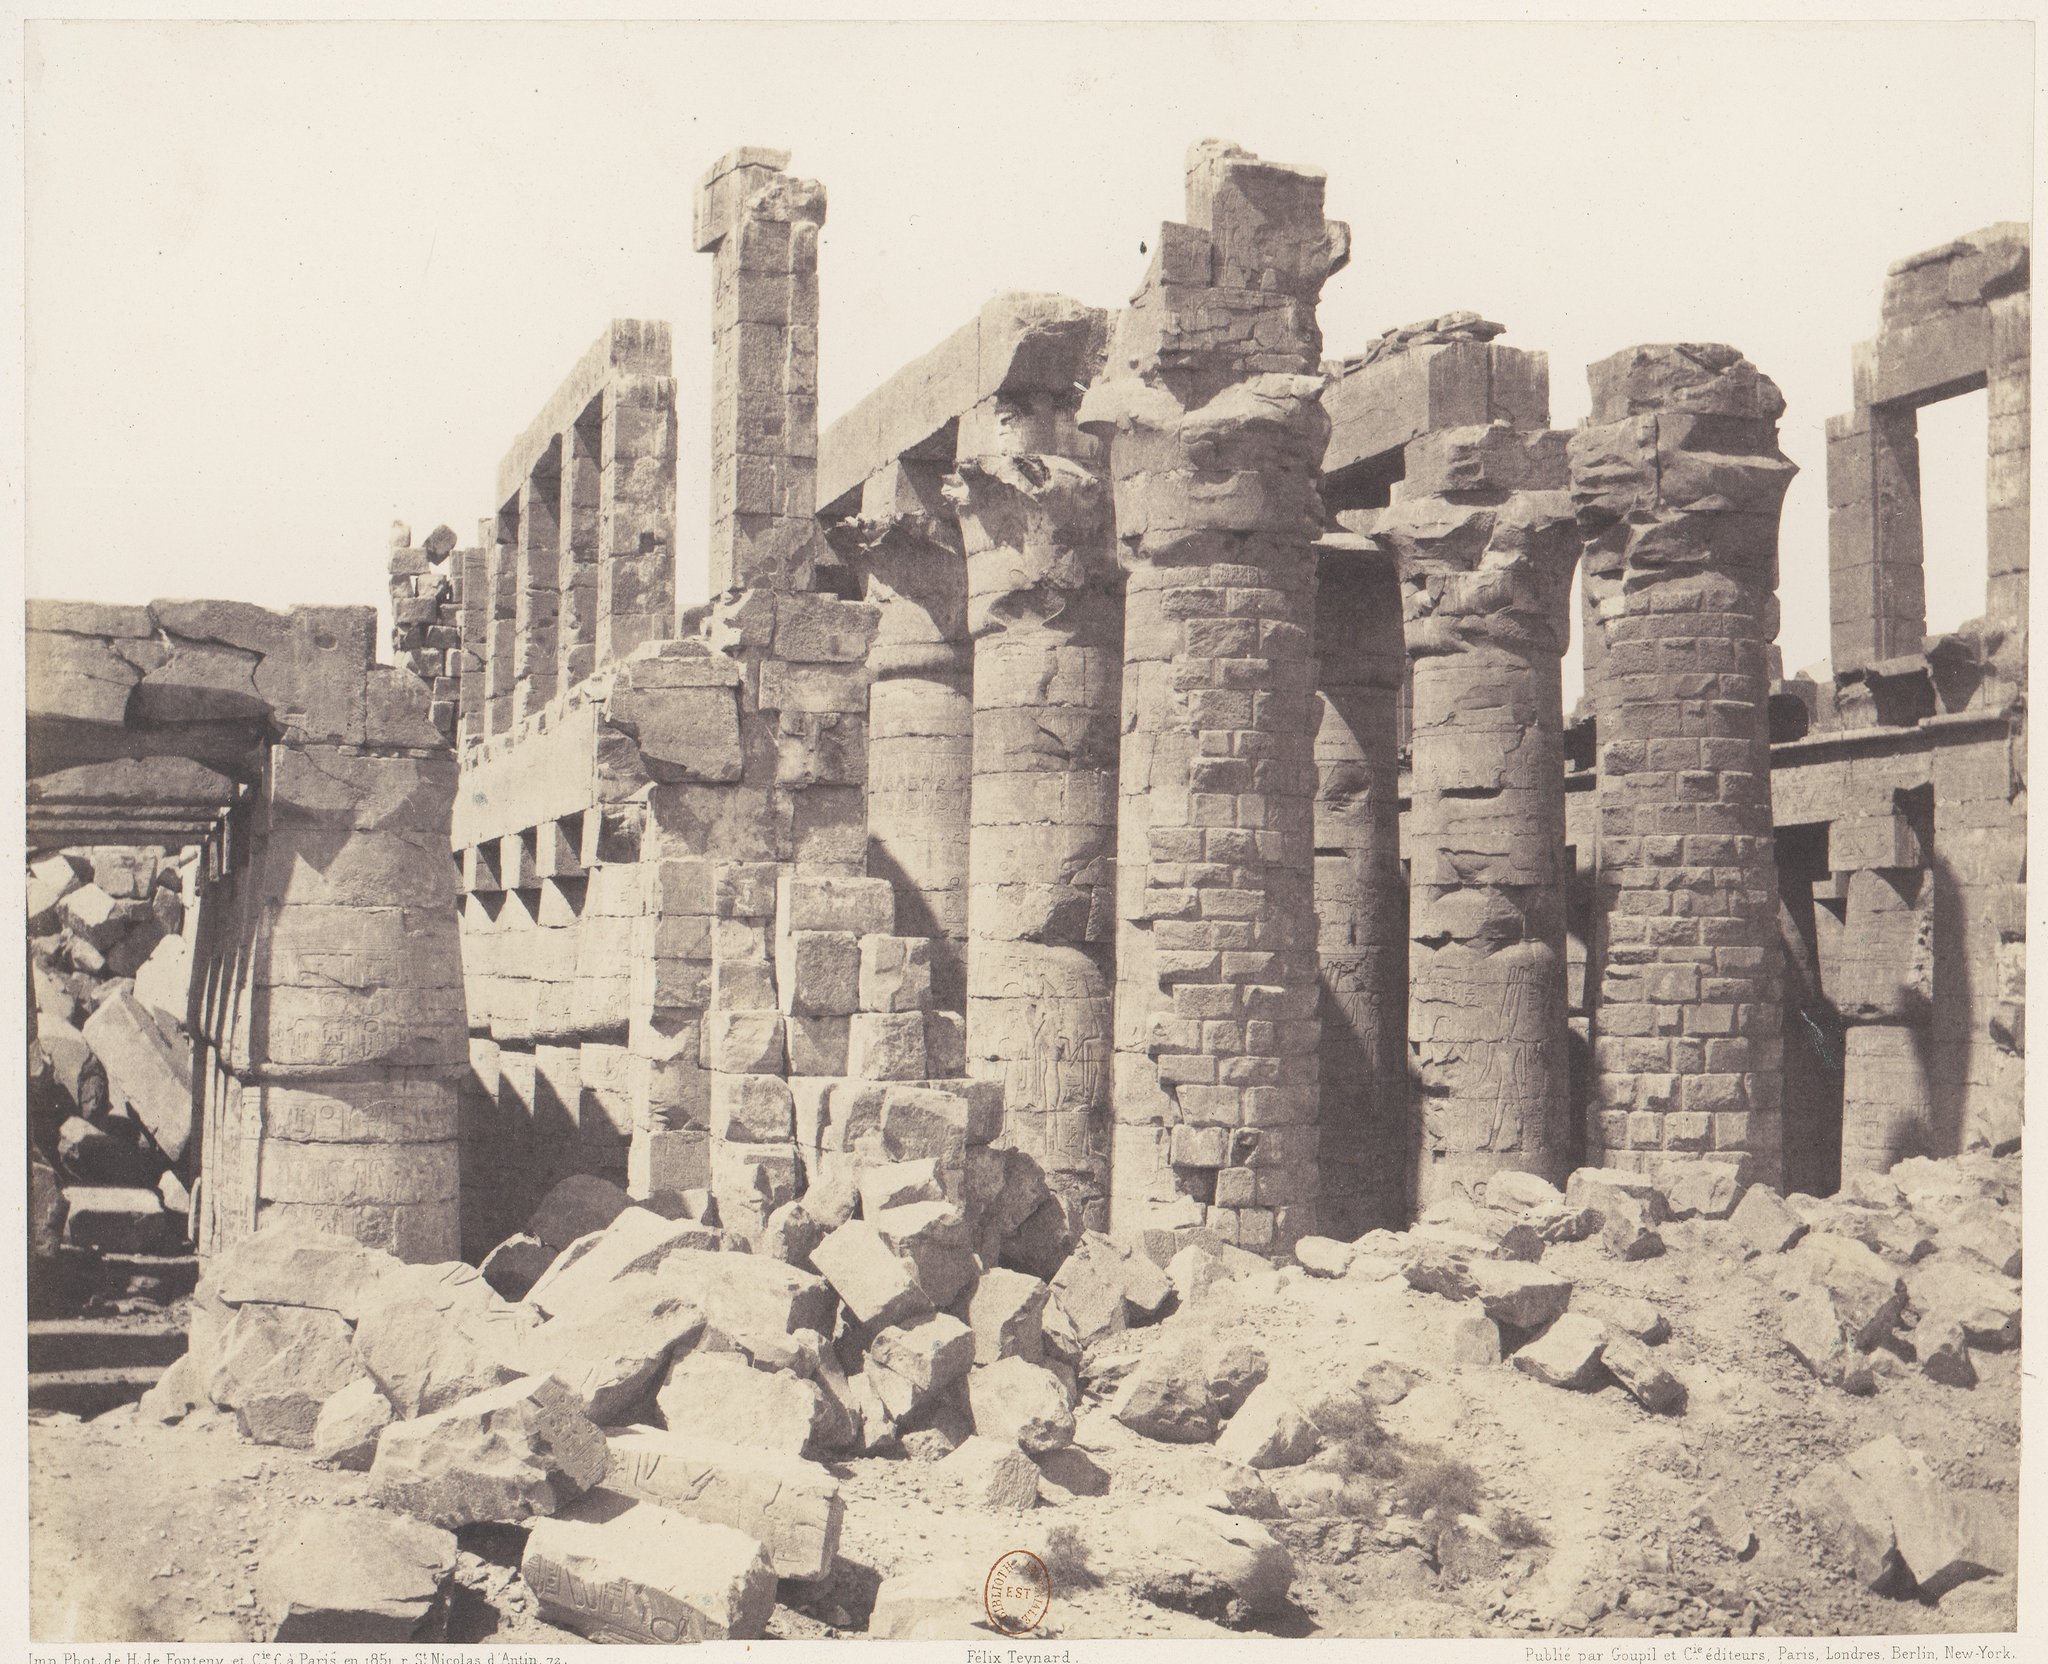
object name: photograph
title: Karnak (Thèbes), Palais - Salle Hypostyle - Vue Générale Prise du Point Q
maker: félix teynard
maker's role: artist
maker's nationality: french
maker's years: 1817-1892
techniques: paper negative, salted paper print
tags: columns,ruins